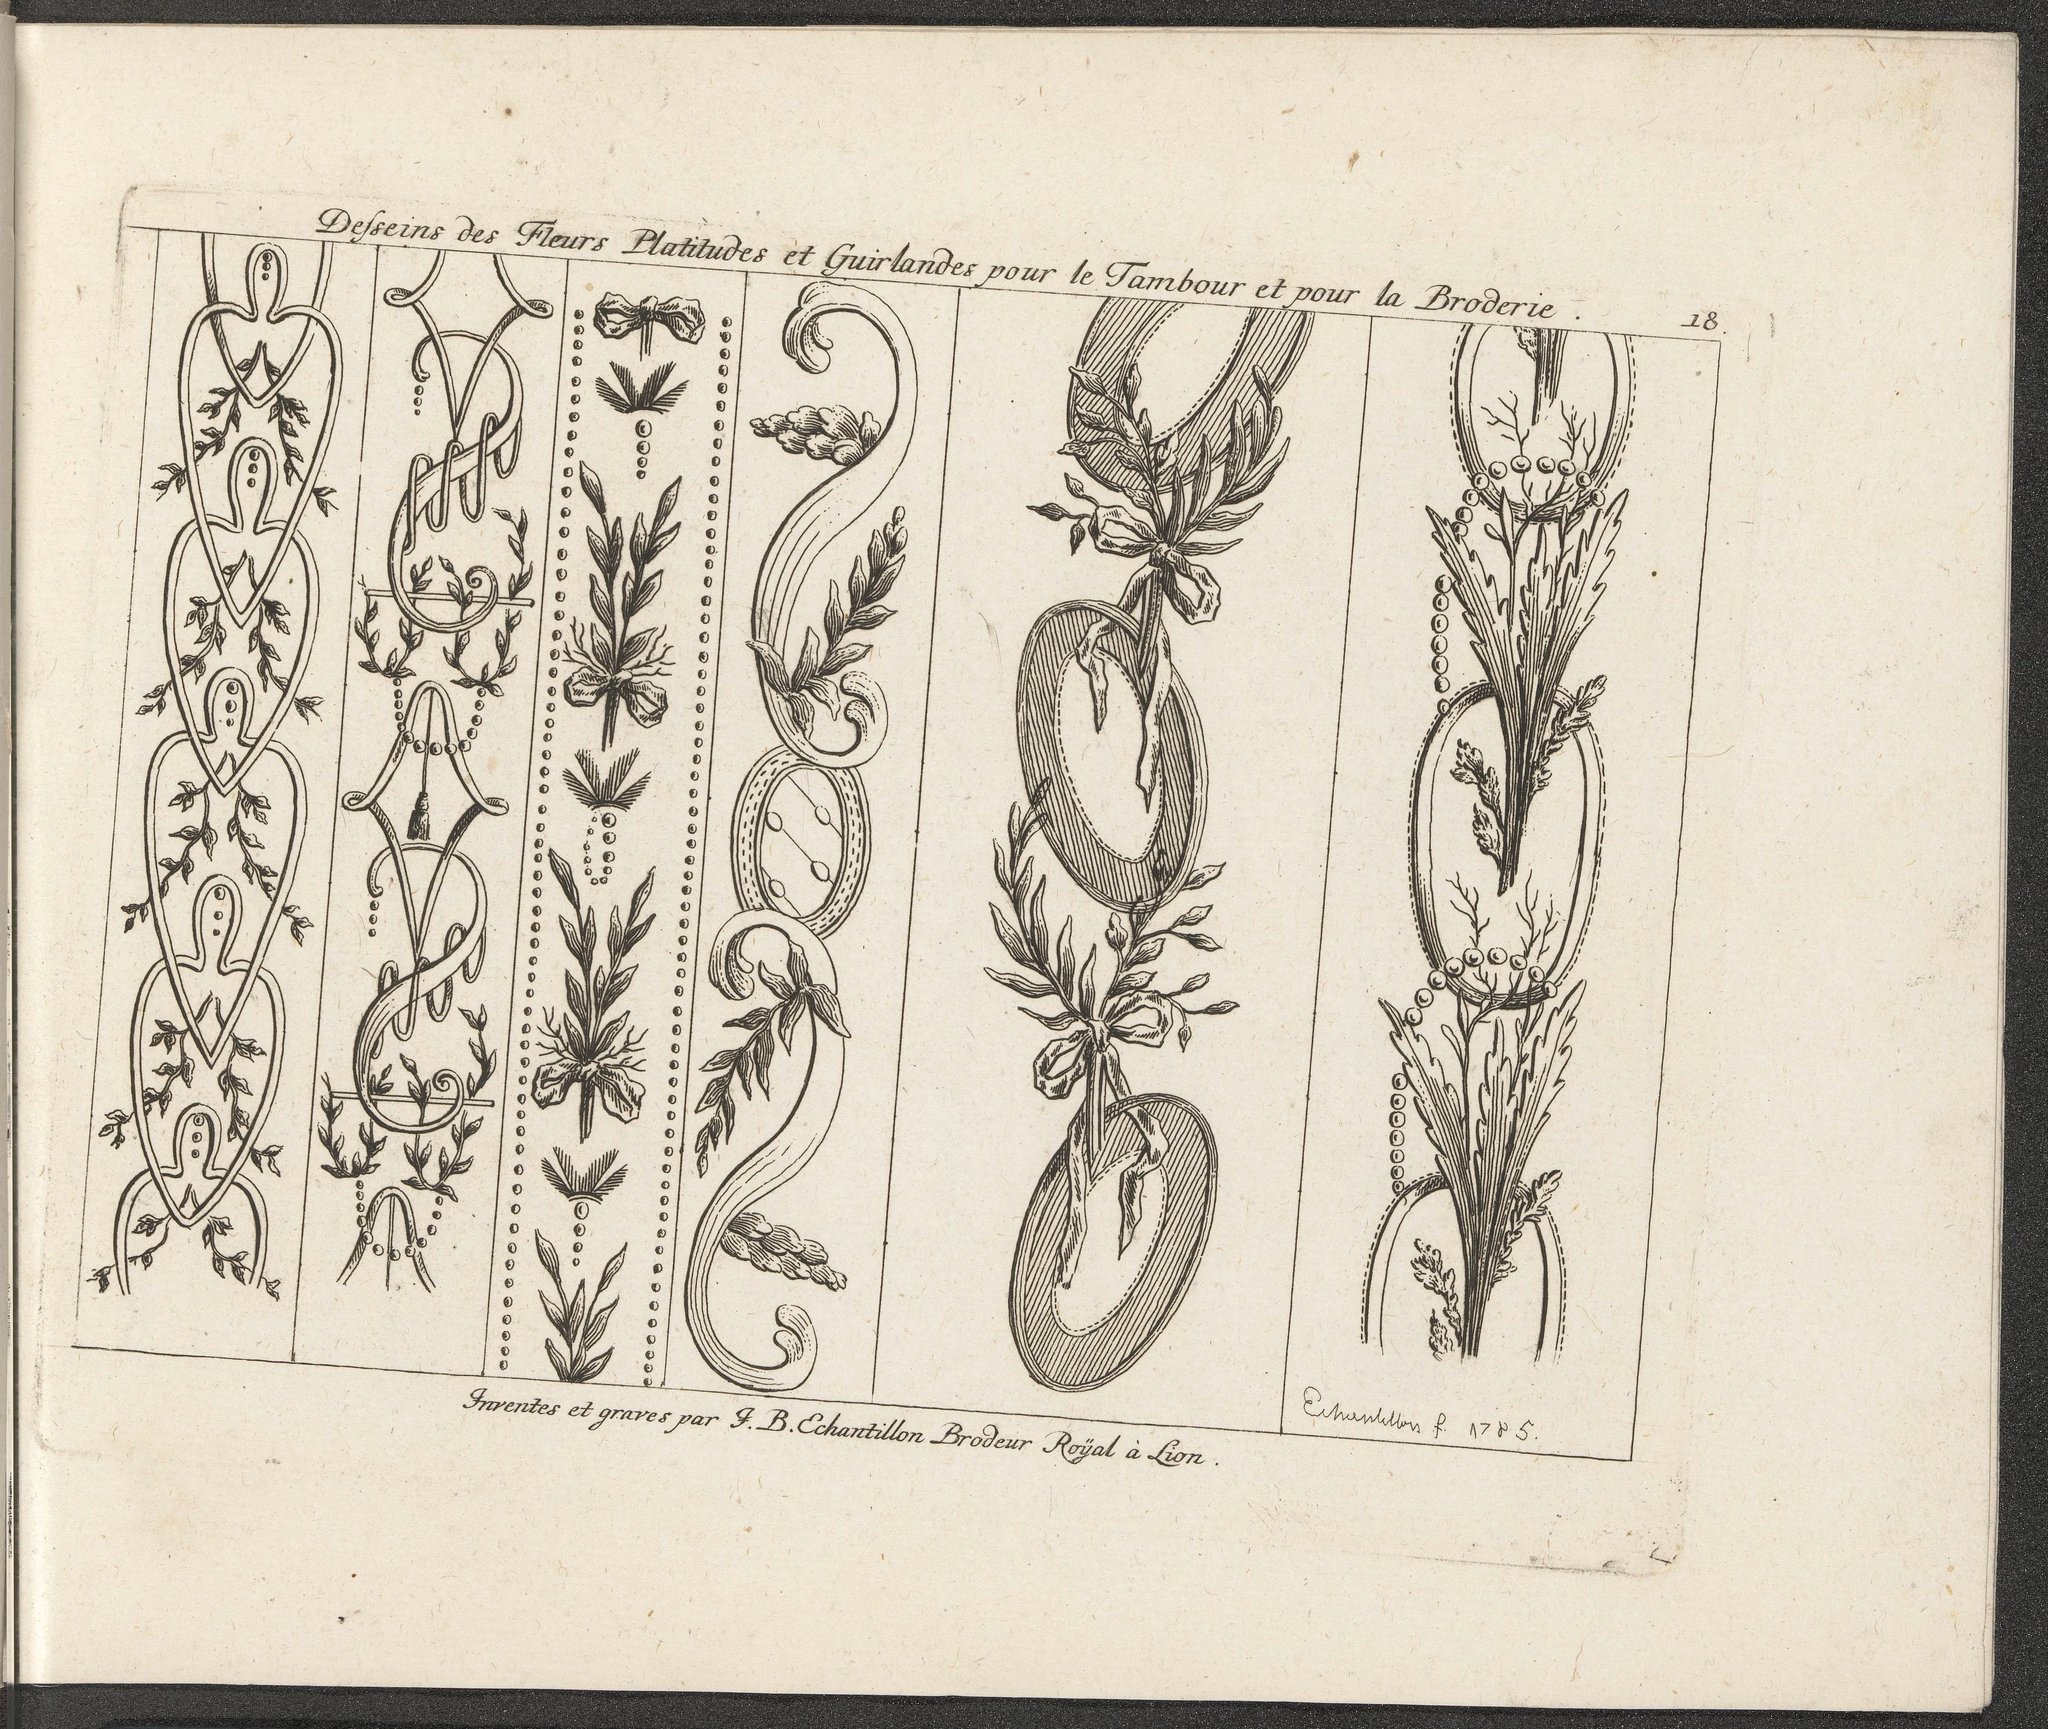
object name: print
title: Desseins des Fleurs Platitudes et Guirlandes pour le Tambour et pour la Broderie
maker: jean baptiste echantillon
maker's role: print maker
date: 1785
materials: paper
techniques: etching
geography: lyon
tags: embroidery (ornamentation)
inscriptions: collector's mark: Lugt 2228, collector's mark: Lugt 2760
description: Zes verticale stroken borduurwerk met bladmotieven en vlechtwerk.